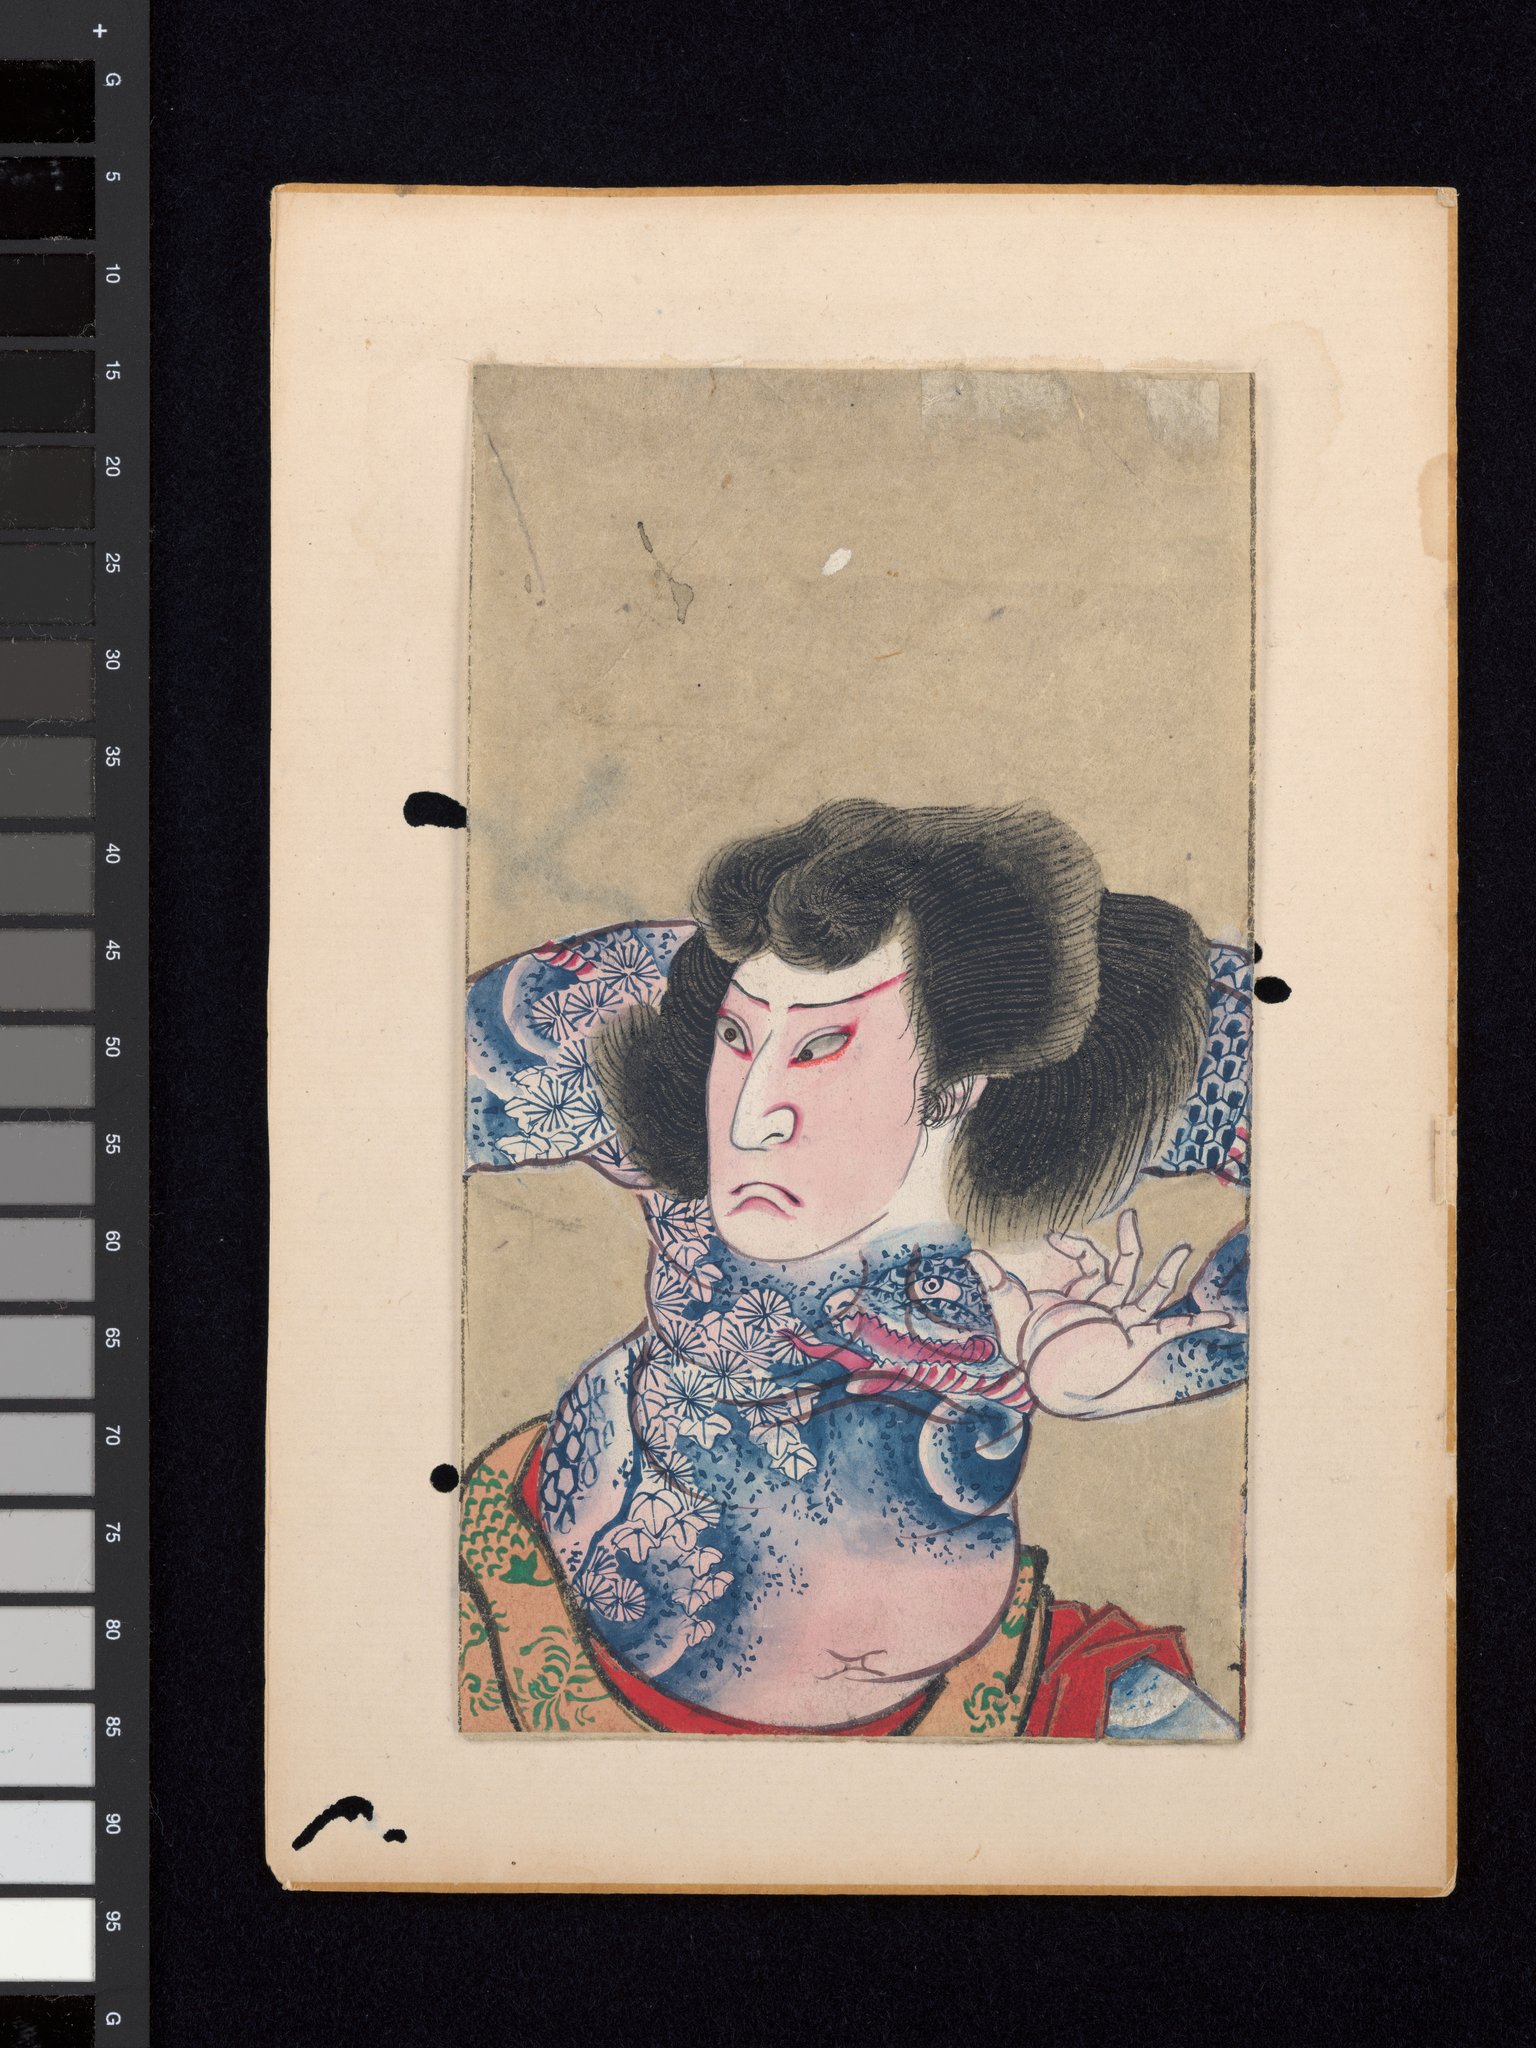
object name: album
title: Album of Twenty Half-Length Portraits of Actors in Roles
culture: japanese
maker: shunbaisai hokuei 春梅斎北英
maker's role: artist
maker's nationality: japanese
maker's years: 1829-1837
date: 1830-1839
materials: ink, paper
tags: portraits,actors